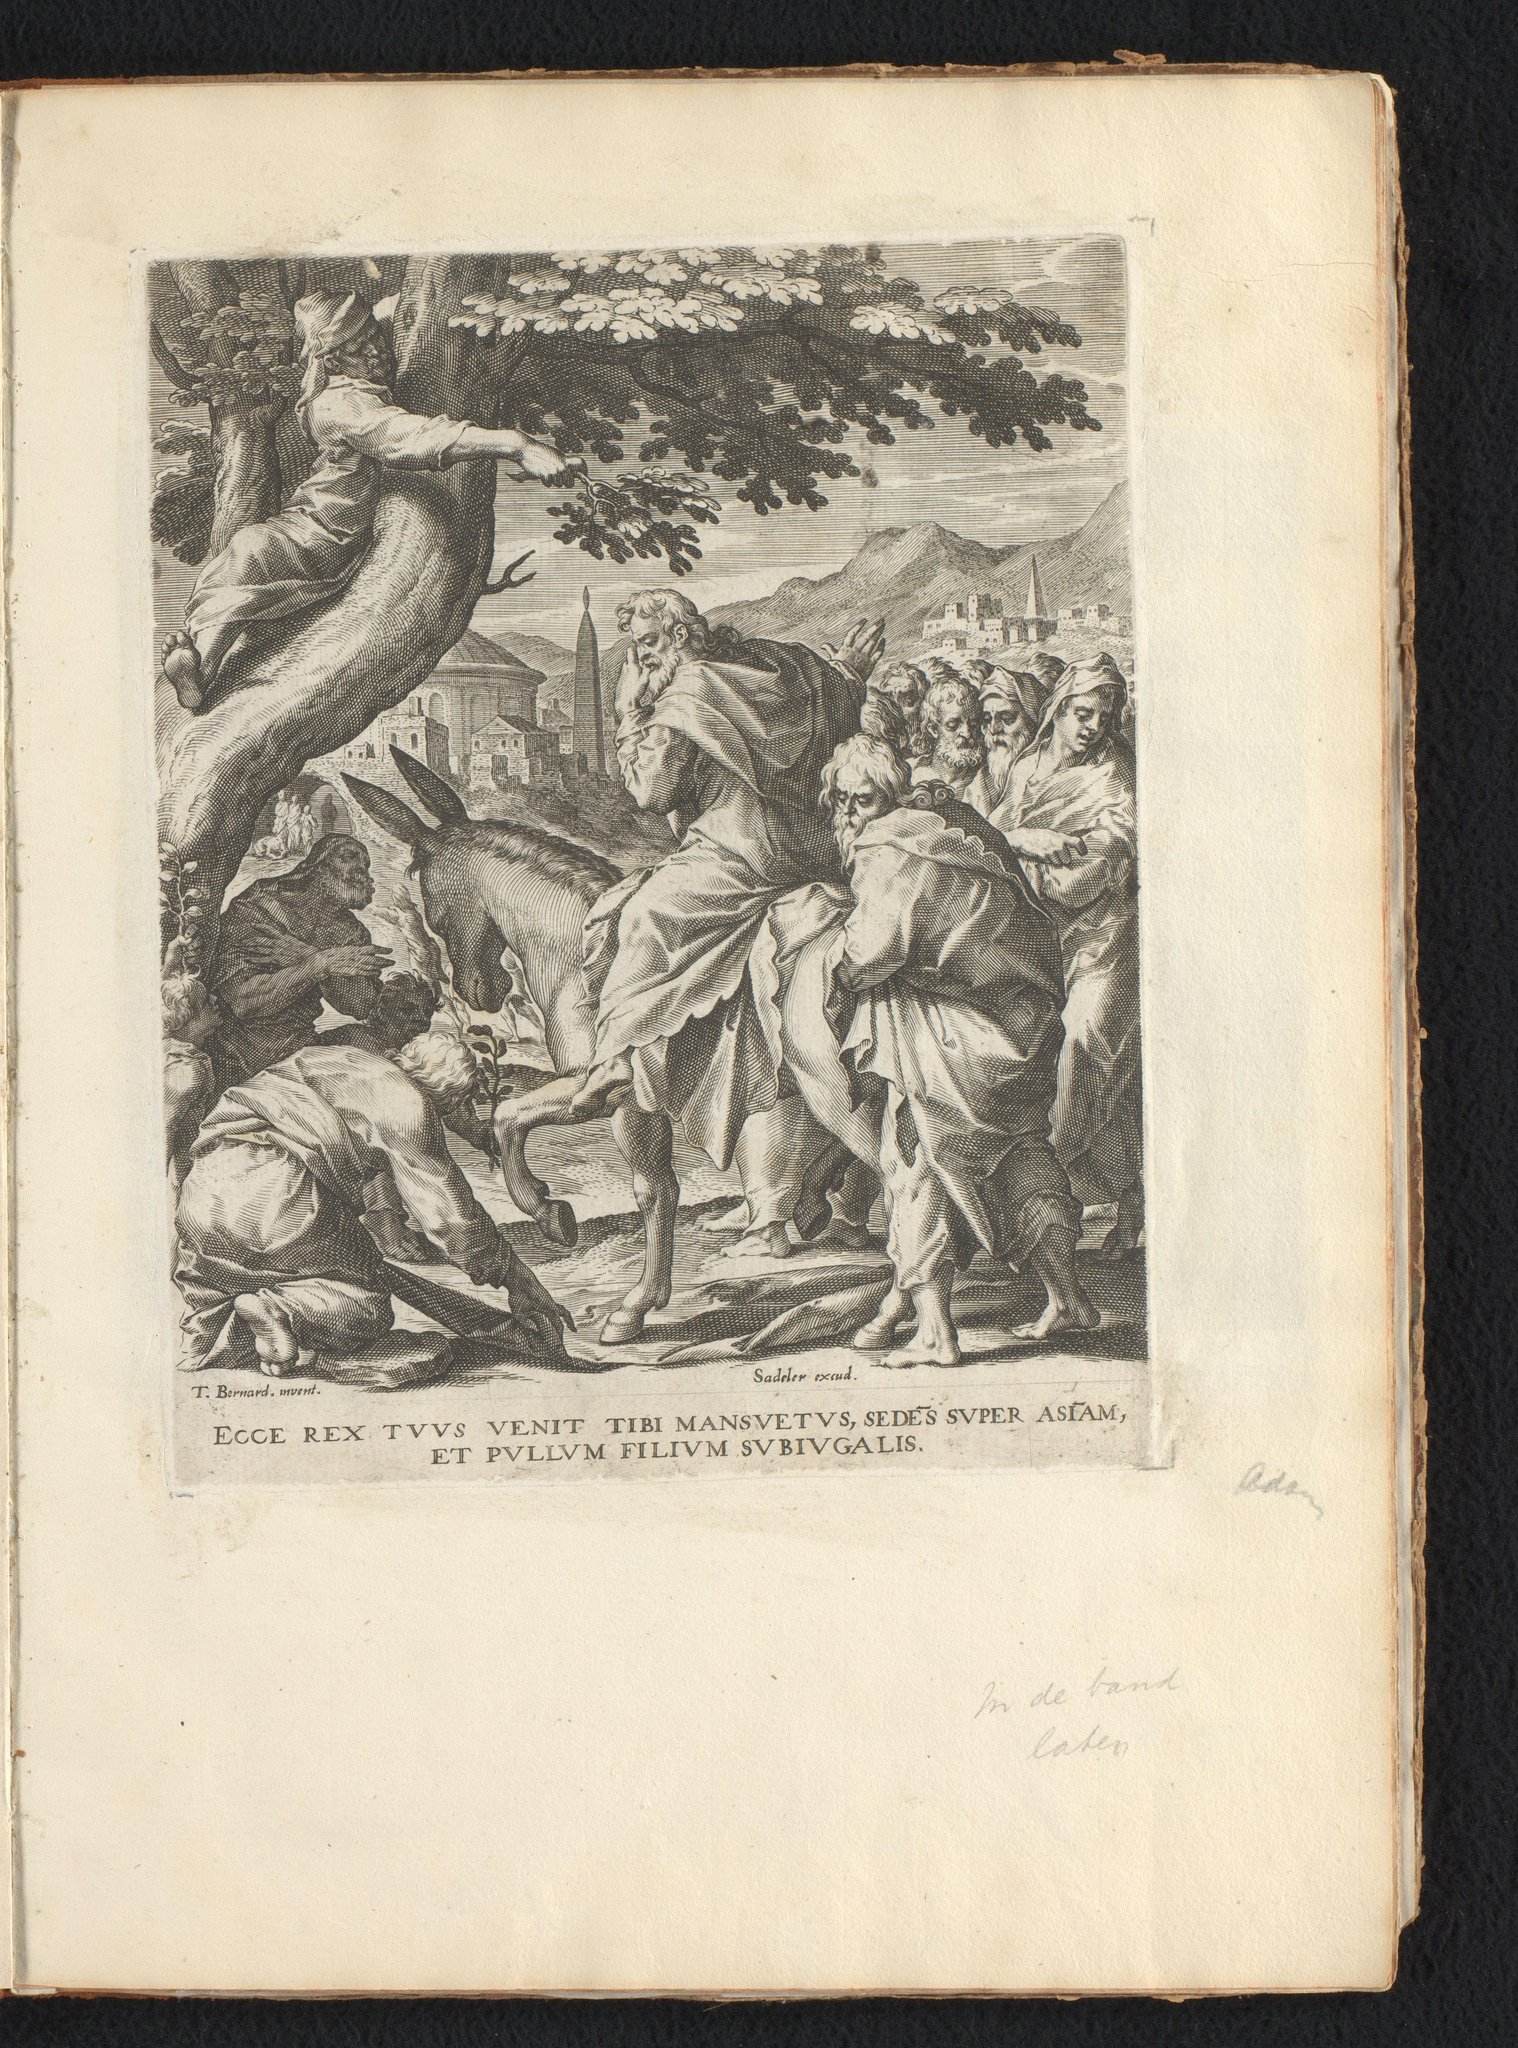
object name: print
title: De waarheid van de boodschap van Christus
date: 1570-1600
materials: paper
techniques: engraving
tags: entry into jerusalem: people spreading their clothes before christ on the ass, and waving palm branches (matthew 21:1-11, 21:14-16; mark 11:1-11; luke 19:28-40; john 12:12-19), doctrine on original sin, and redemption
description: Christus, op een ezel, rijdt Jeruzalem binnen. Rondom hem zwaaien mensen met palmtakken. Een man legt zijn mantel voor Christus neer op de grond. Een andere man is in een boom geklommen. Deze prent maakt deel uit van een album.